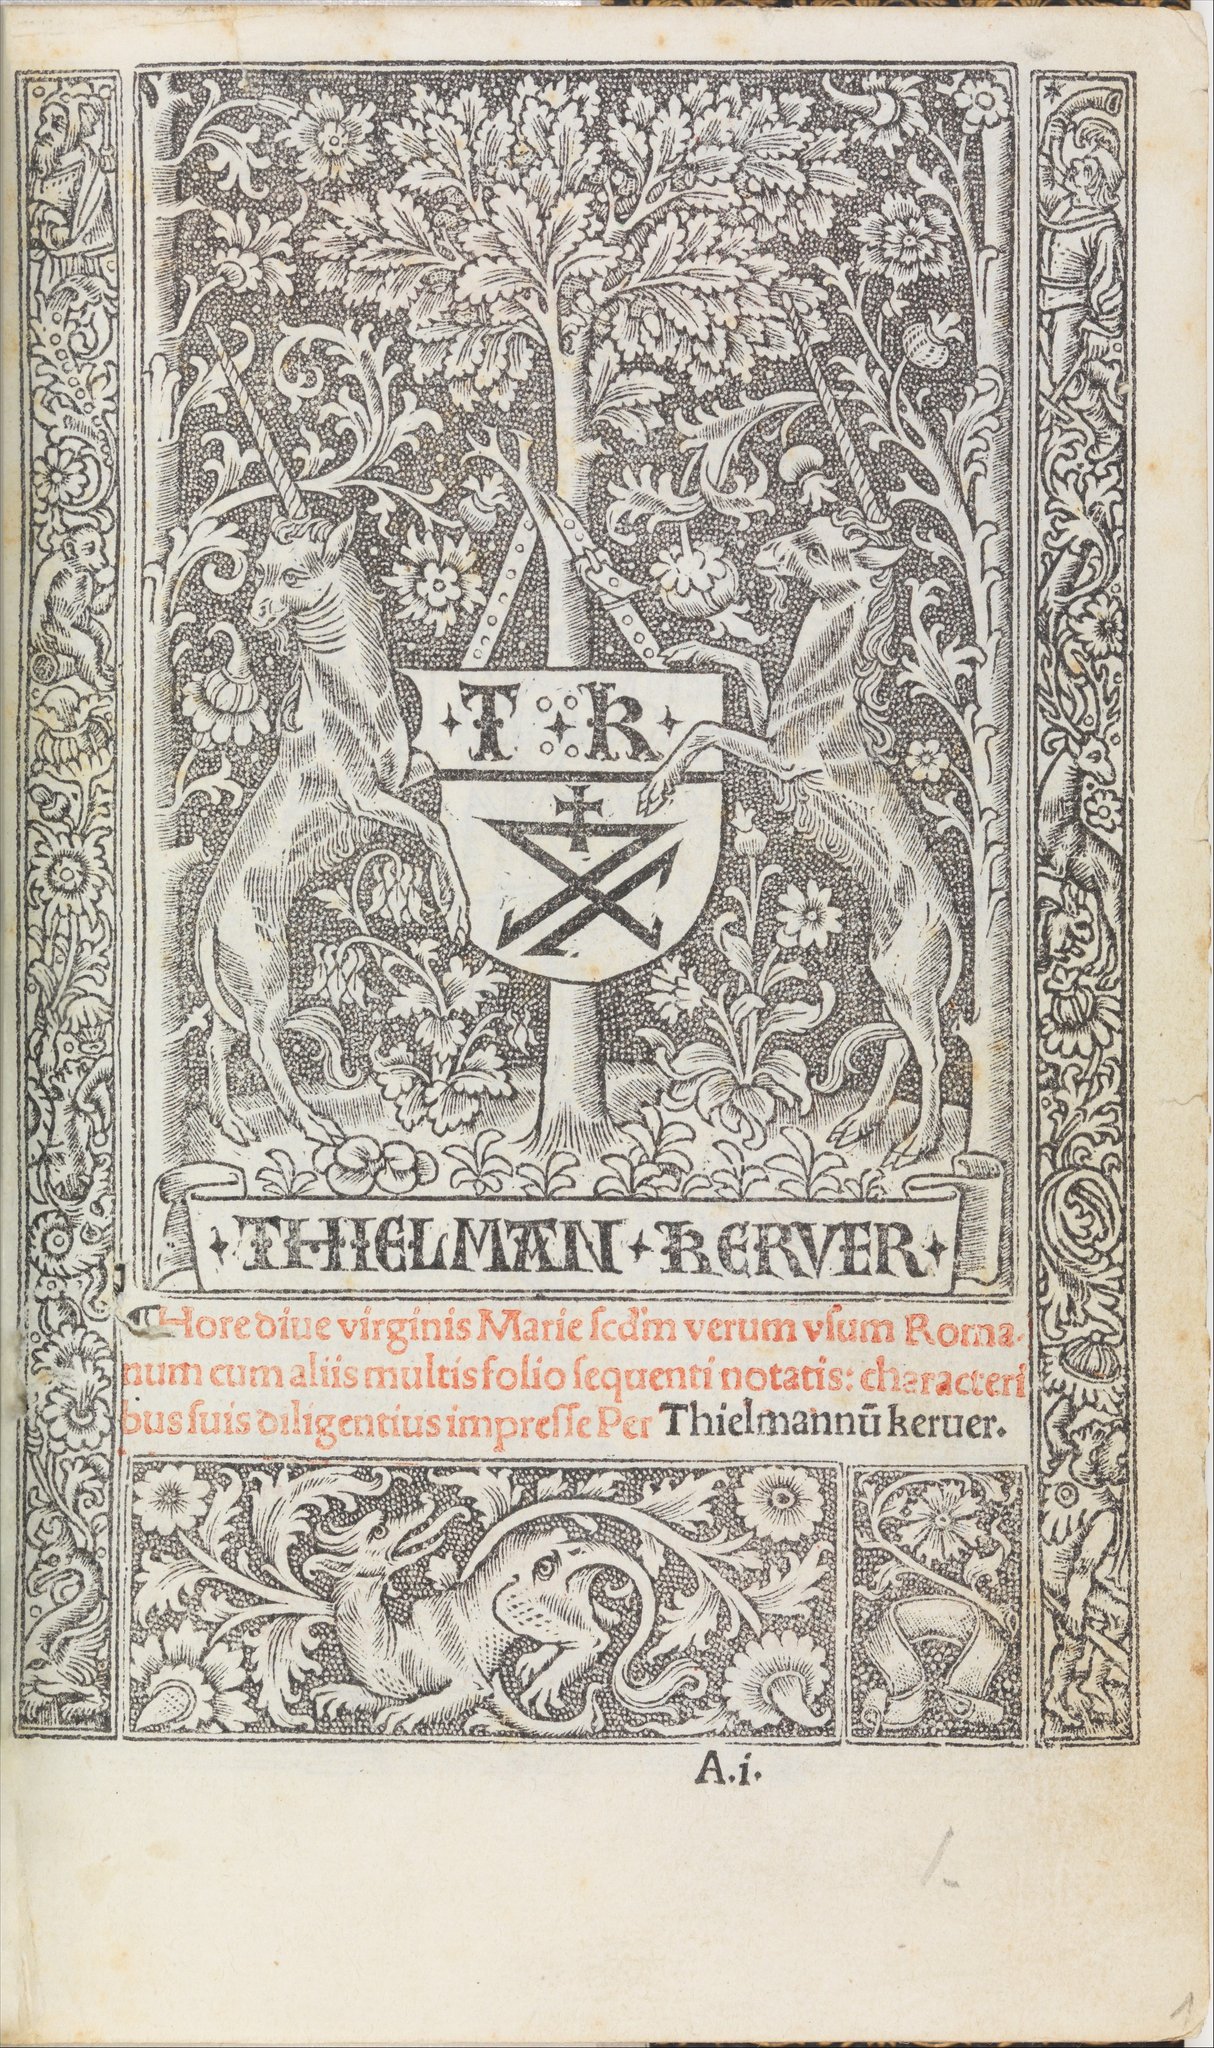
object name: book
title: Horae, B.M.V. use of Rome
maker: thielman kerver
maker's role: publisher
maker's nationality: french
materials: paper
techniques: printing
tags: unicorns,leaves,coat of arms